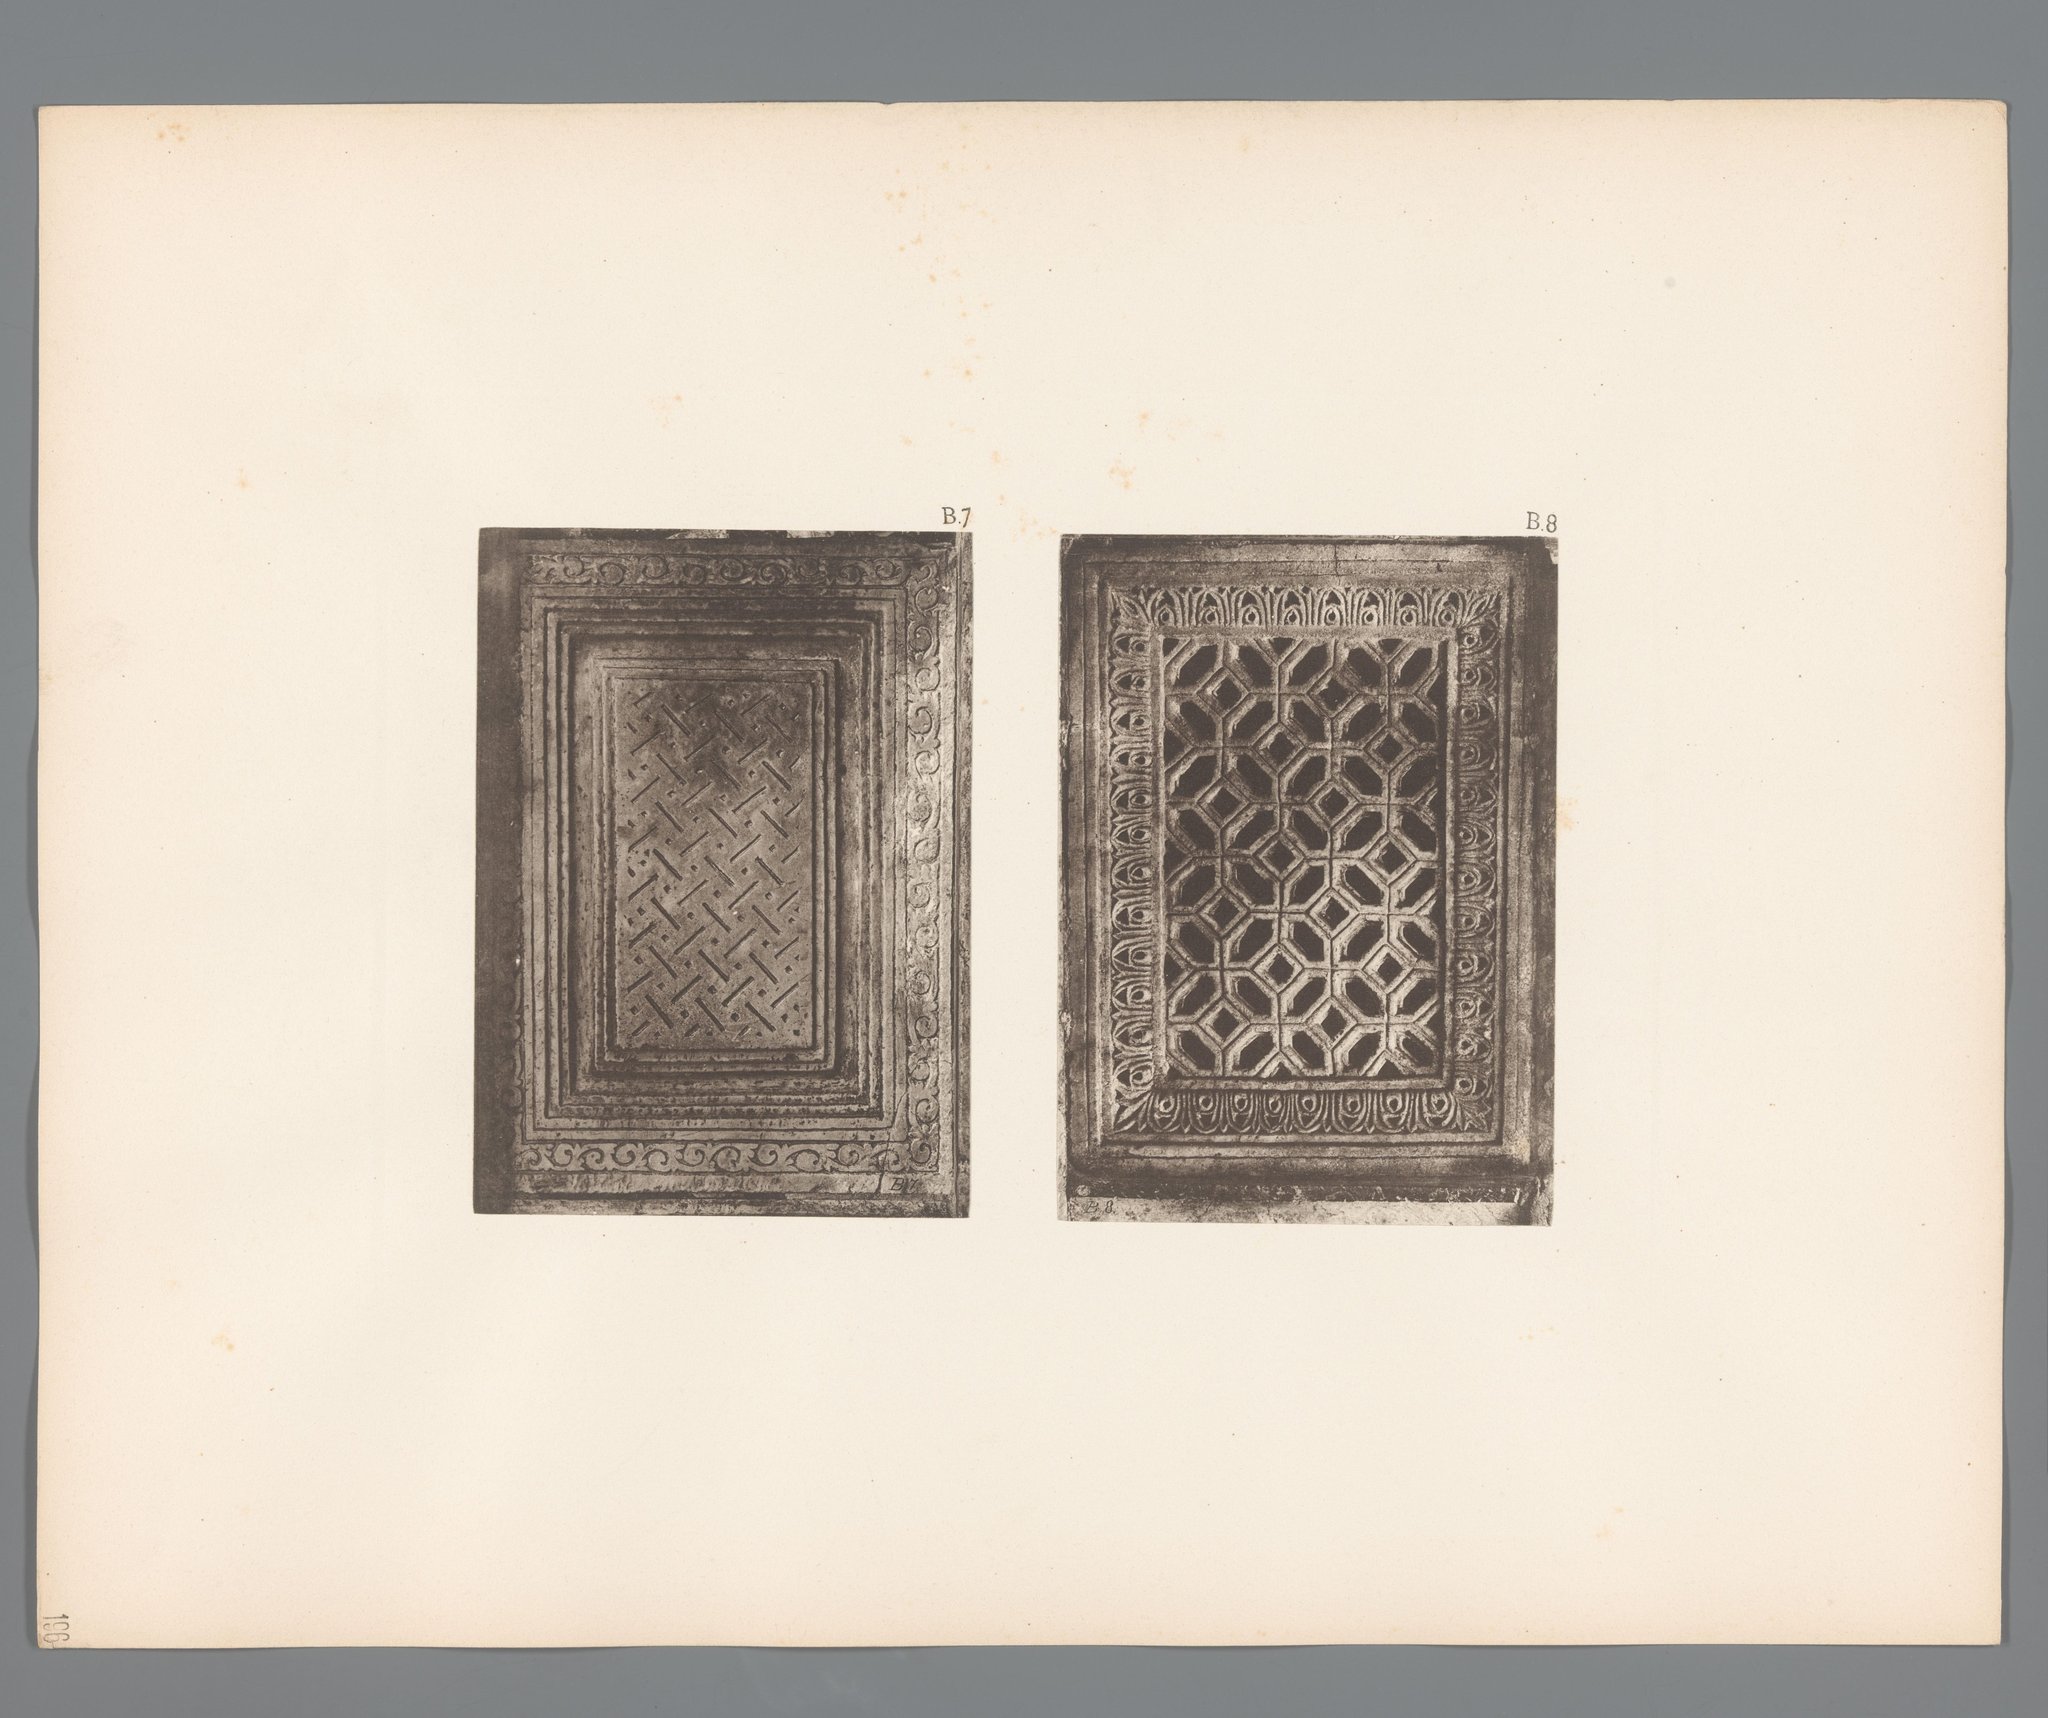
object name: photomechanical print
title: Twee afbeeldingen van details van de San Marco in Venetië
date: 1880-1885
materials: paper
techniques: photograph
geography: venice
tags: architectural detail, piece of sculpture, reproduction of a piece of sculpture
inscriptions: number: ‘B.7.’, number: ‘B.8.’, number: ‘196’, number: ‘B.8’, number: ‘B.7’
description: Deze prenten maken deel uit van een omslag met 79 prenten op 53 bladen en 2 tekstbladen.